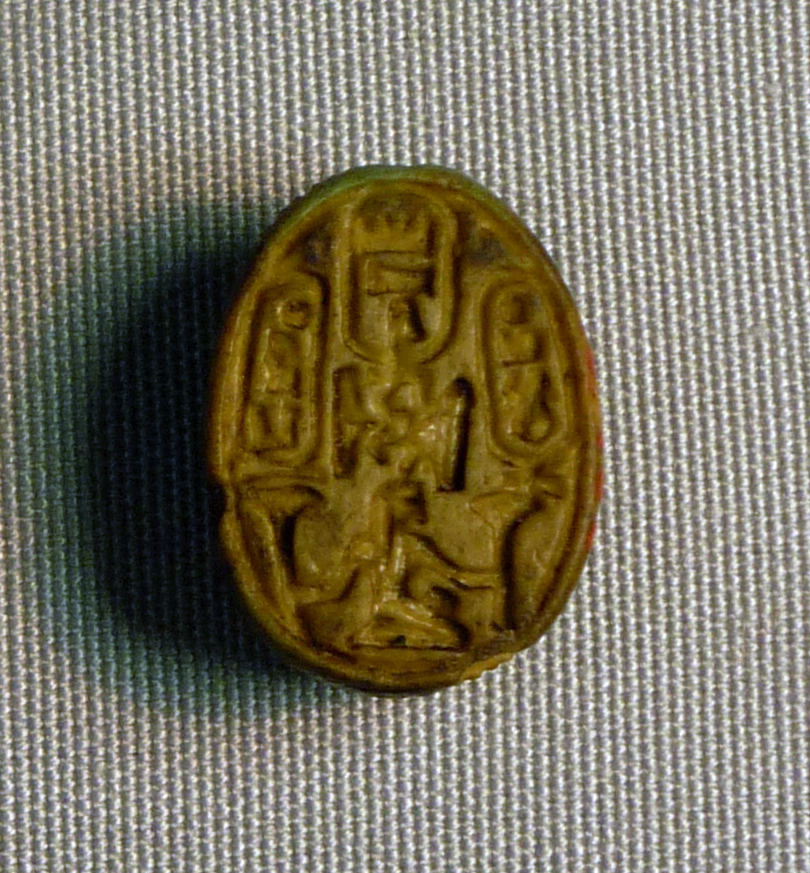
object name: scarab, menkheperre, maatkare, men menes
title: Scarab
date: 1479-1458 BCE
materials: faience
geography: egypt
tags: scarabs